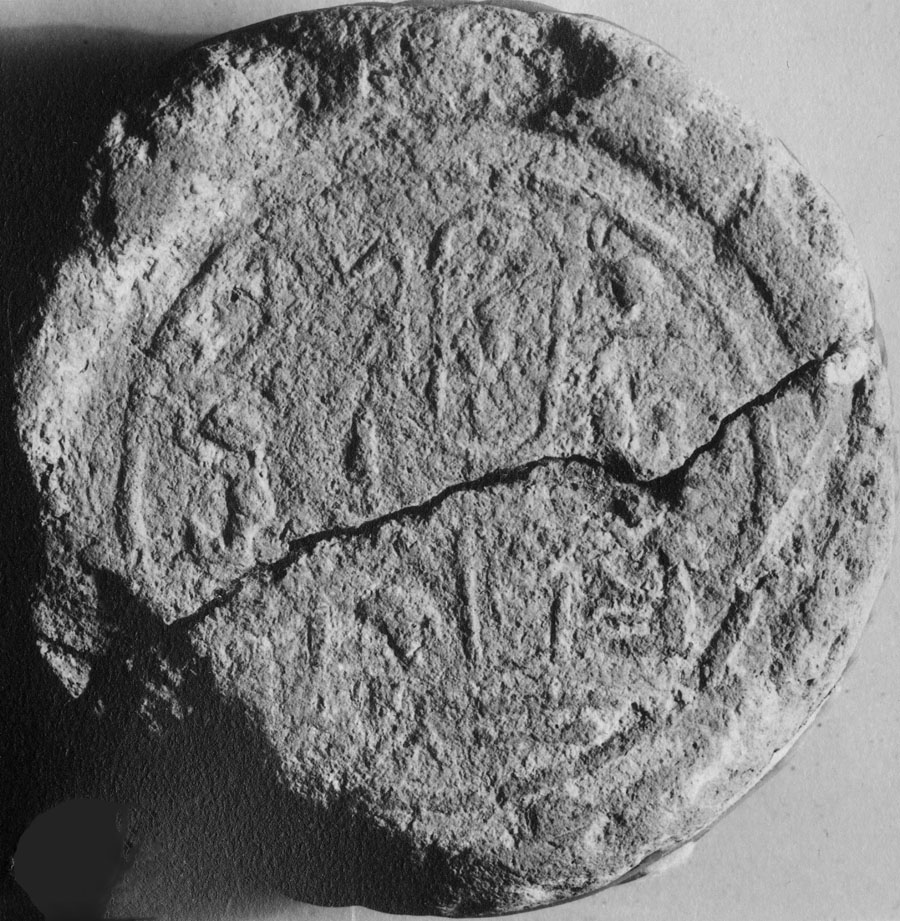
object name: cone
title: Funerary Cone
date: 1550-1295 BCE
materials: pottery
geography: egypt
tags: hieroglyphs